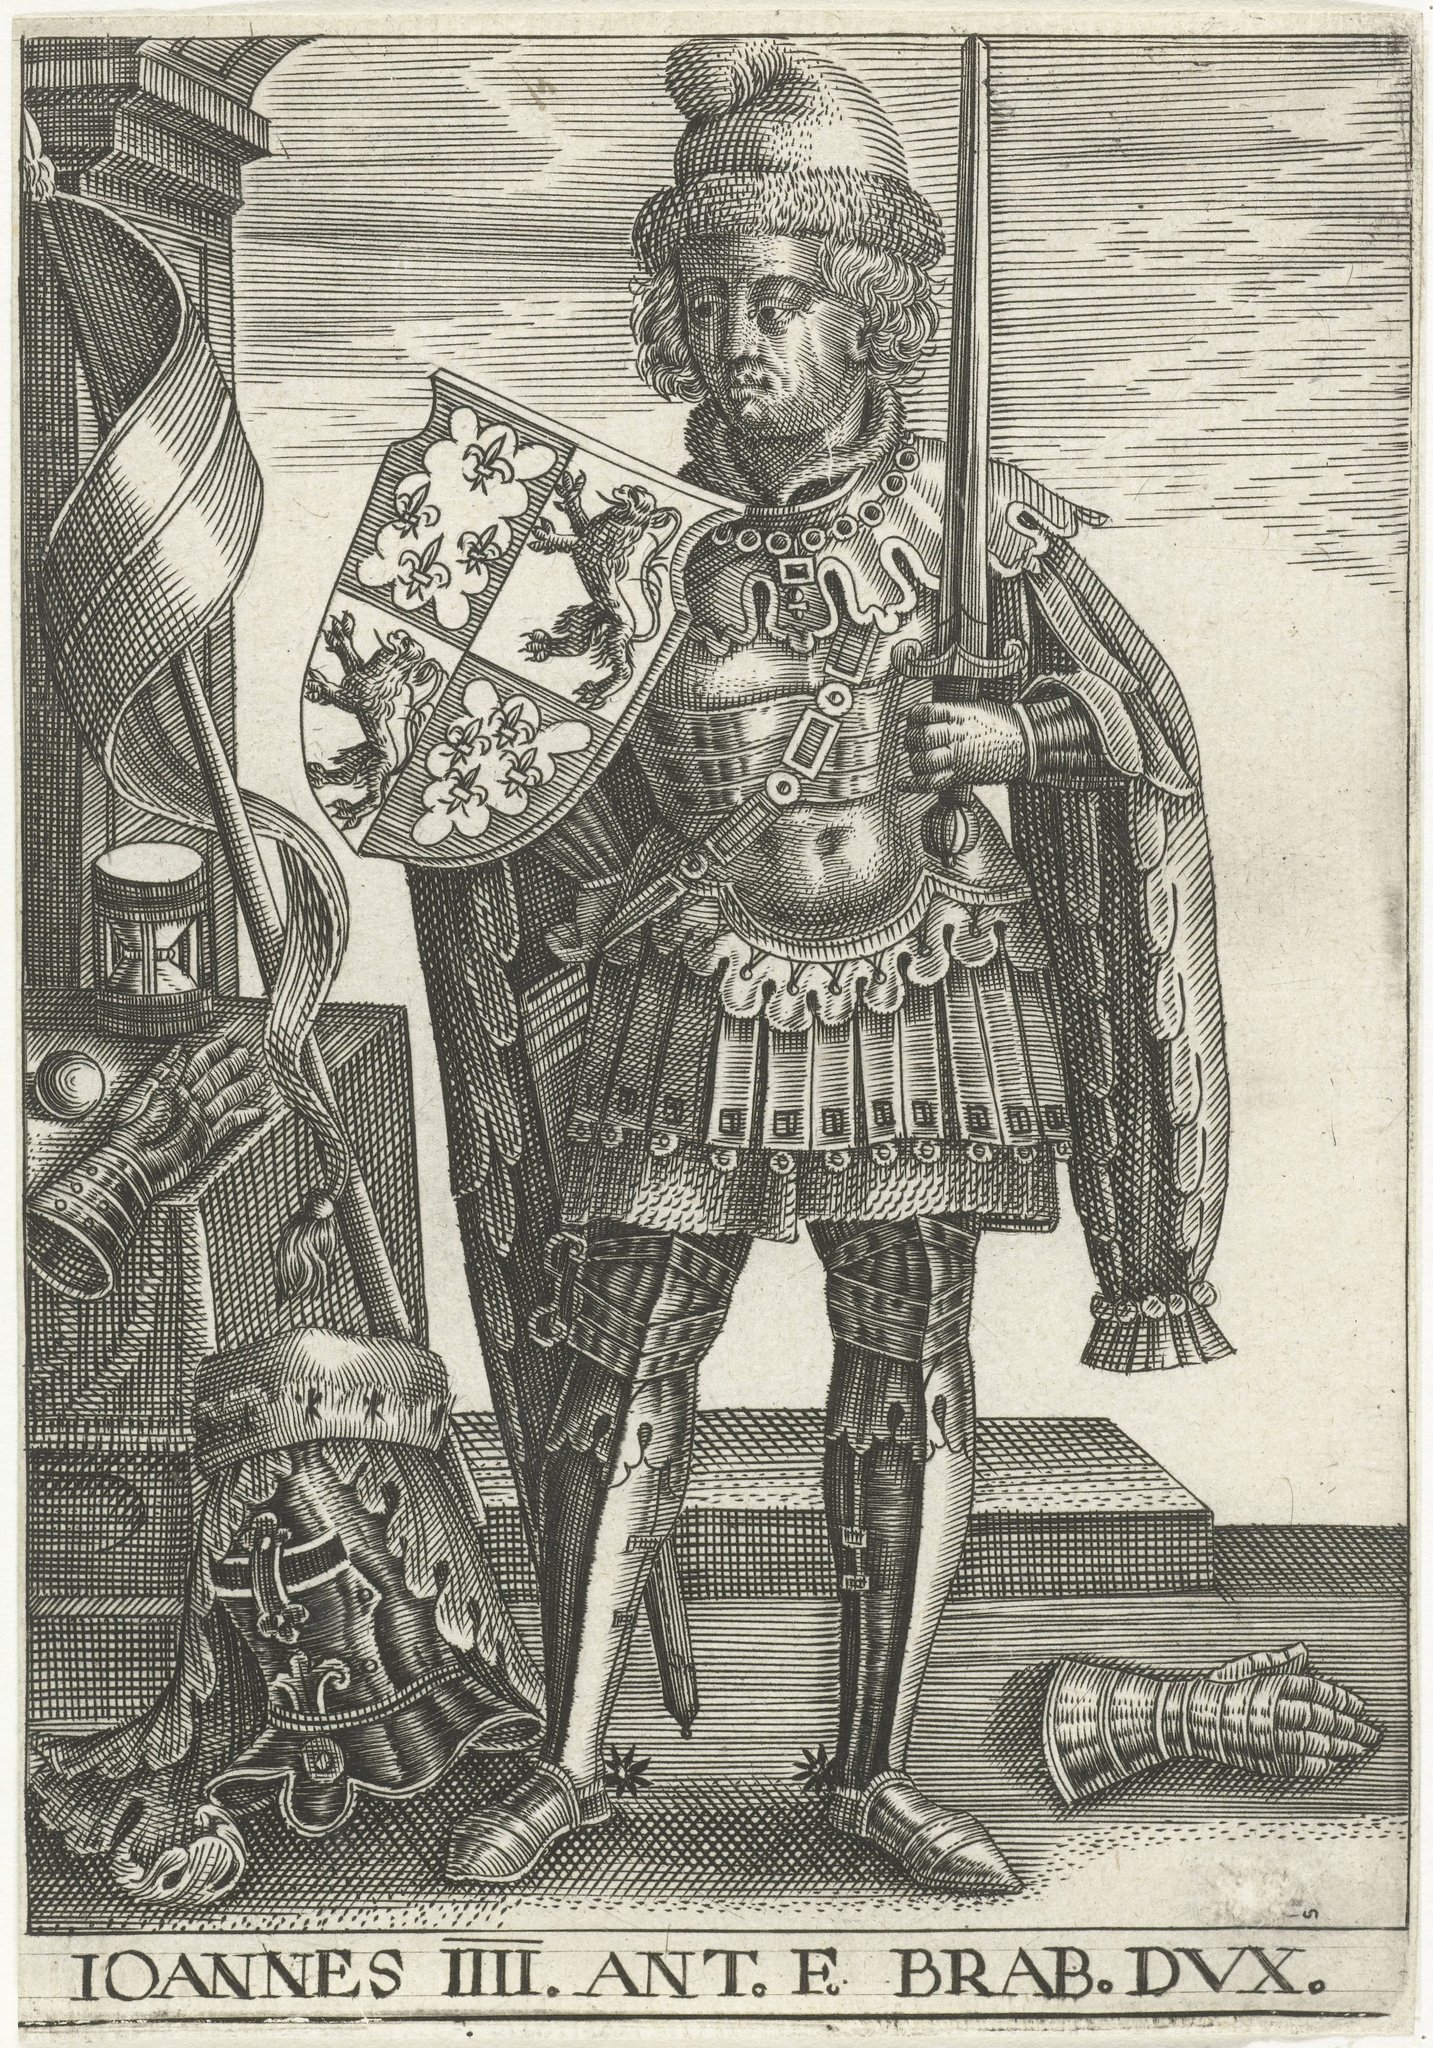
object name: book illustration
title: Portret van Jan IV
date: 1600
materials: paper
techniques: engraving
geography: antwerp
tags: brussels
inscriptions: collector's mark: Lugt 2228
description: Portret van Jan IV, hertog van Brabant. Staande, ten voeten uit, in volle wapenrusting. Jan heeft een wapenschild in zijn rechterhand en een zwaard in zijn linkerhand.